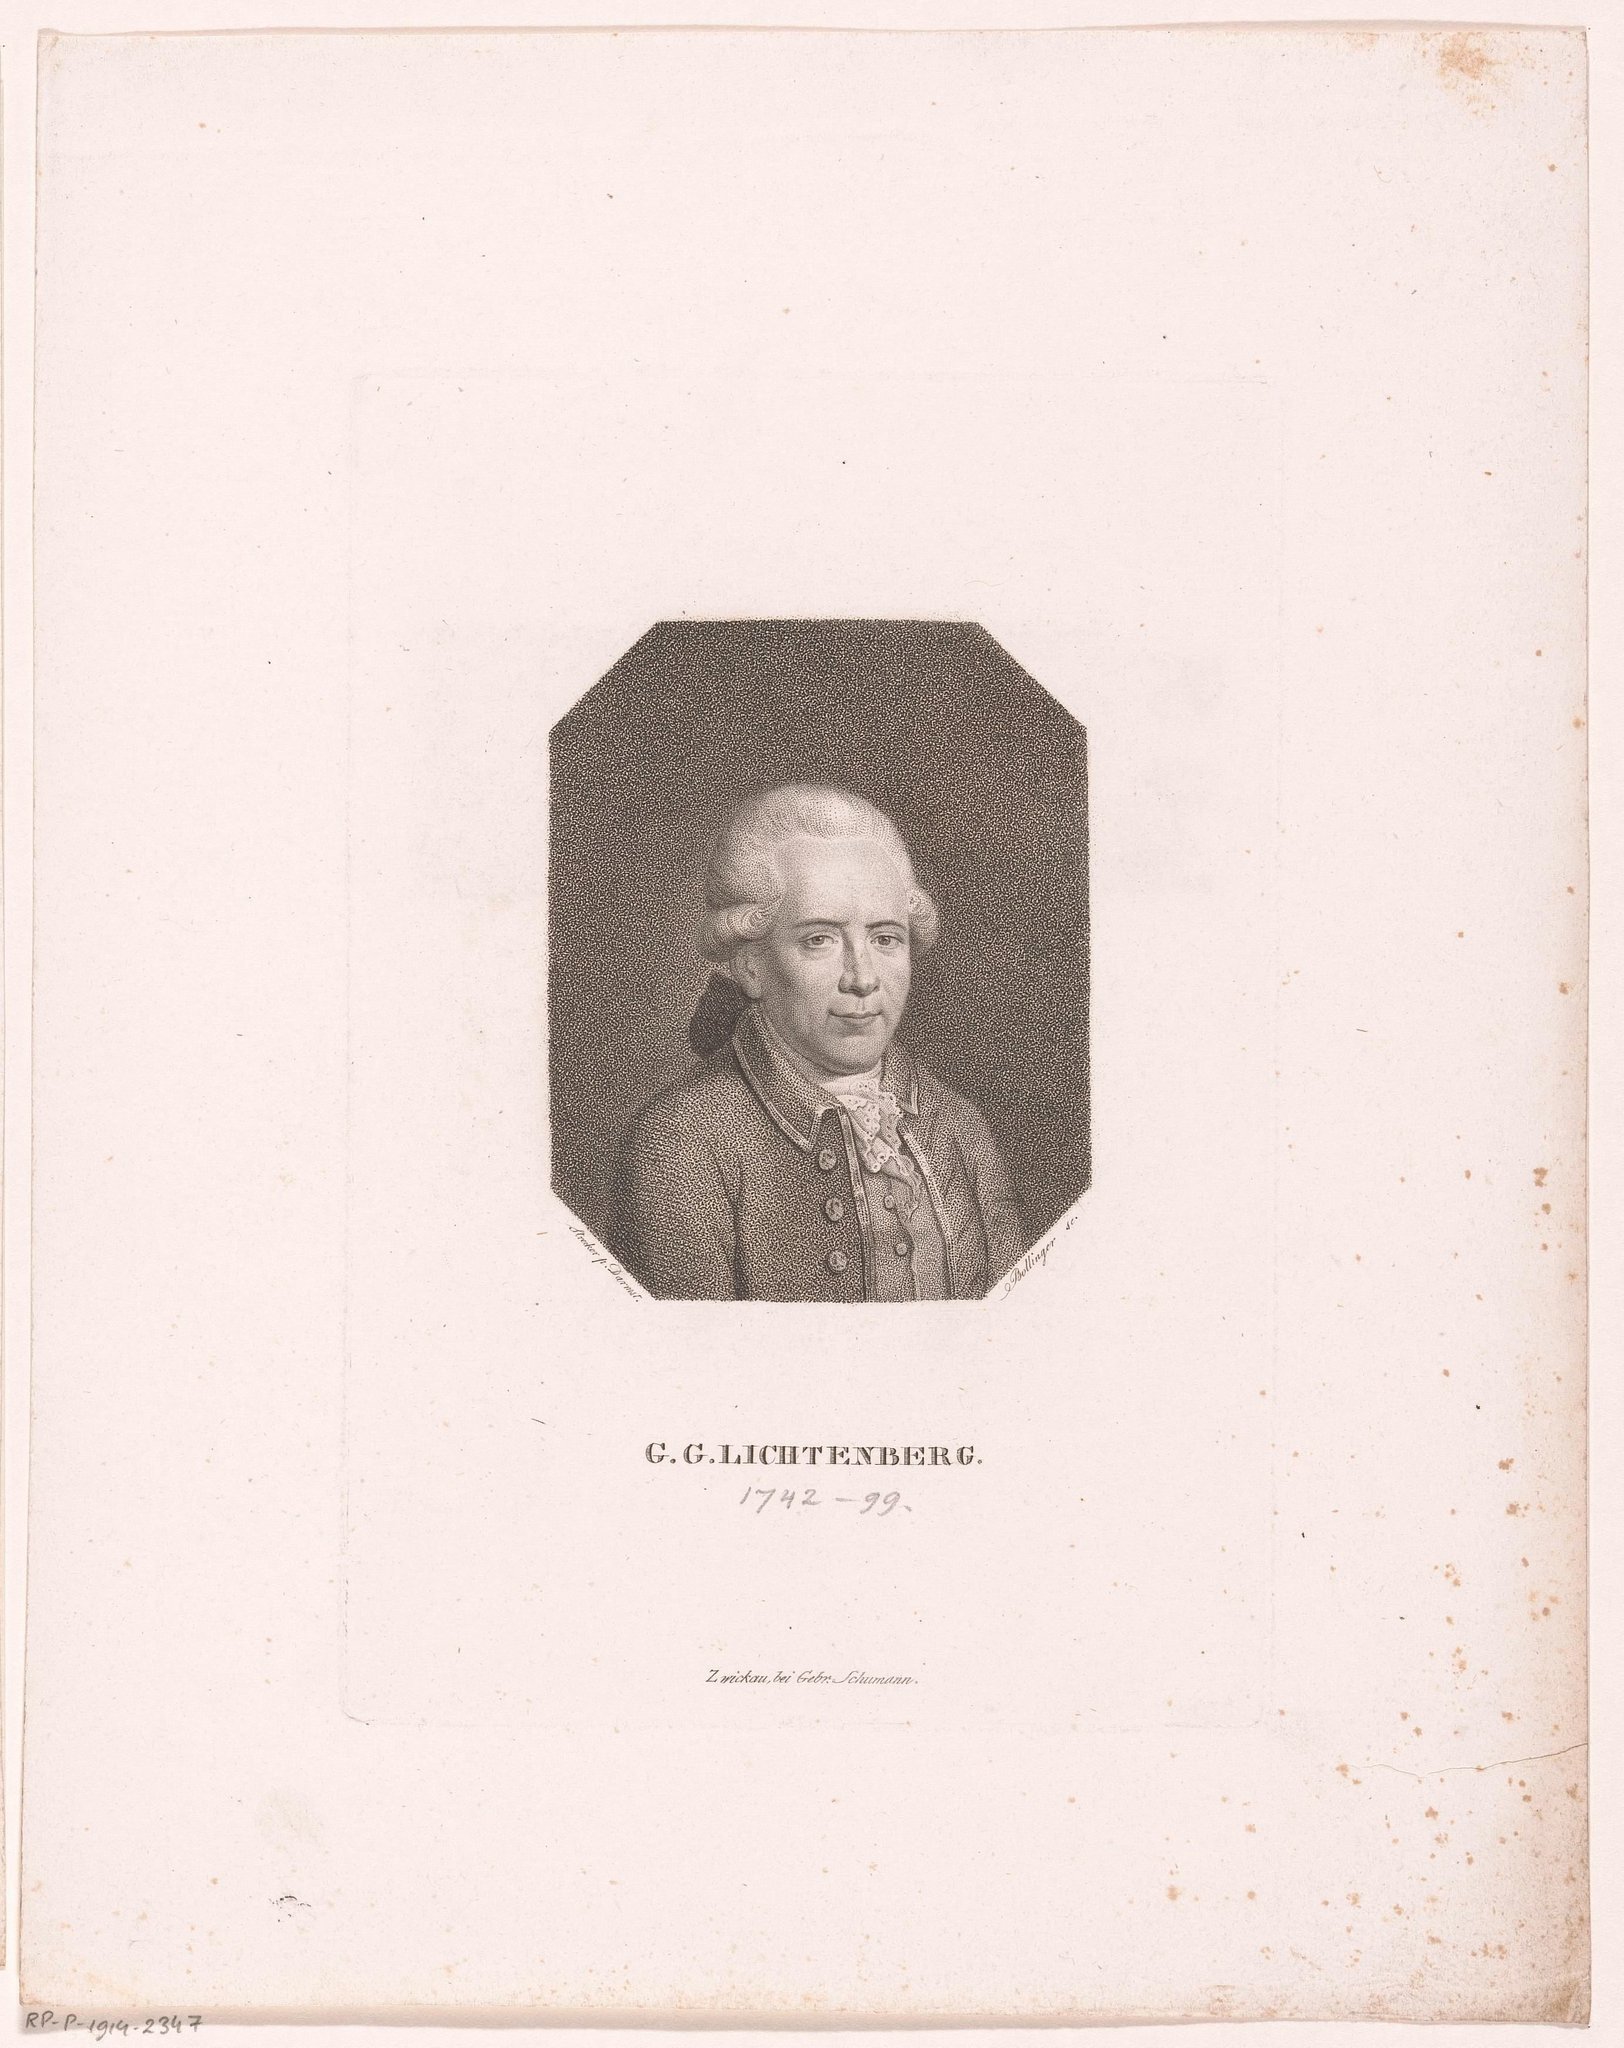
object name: print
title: Portret van Georg Christoph Lichtenberg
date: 1818-1832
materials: paper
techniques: stippling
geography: zwickau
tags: physicist, historical persons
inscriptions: collector's mark: Lugt 2228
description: Prent gebruikt door de serie 'Bildnisse der berühmtesten Menschen aller Völker und Zeiten' van de gebroeders Schumann, uitgegeven in 1818-1832 te Zwickau.